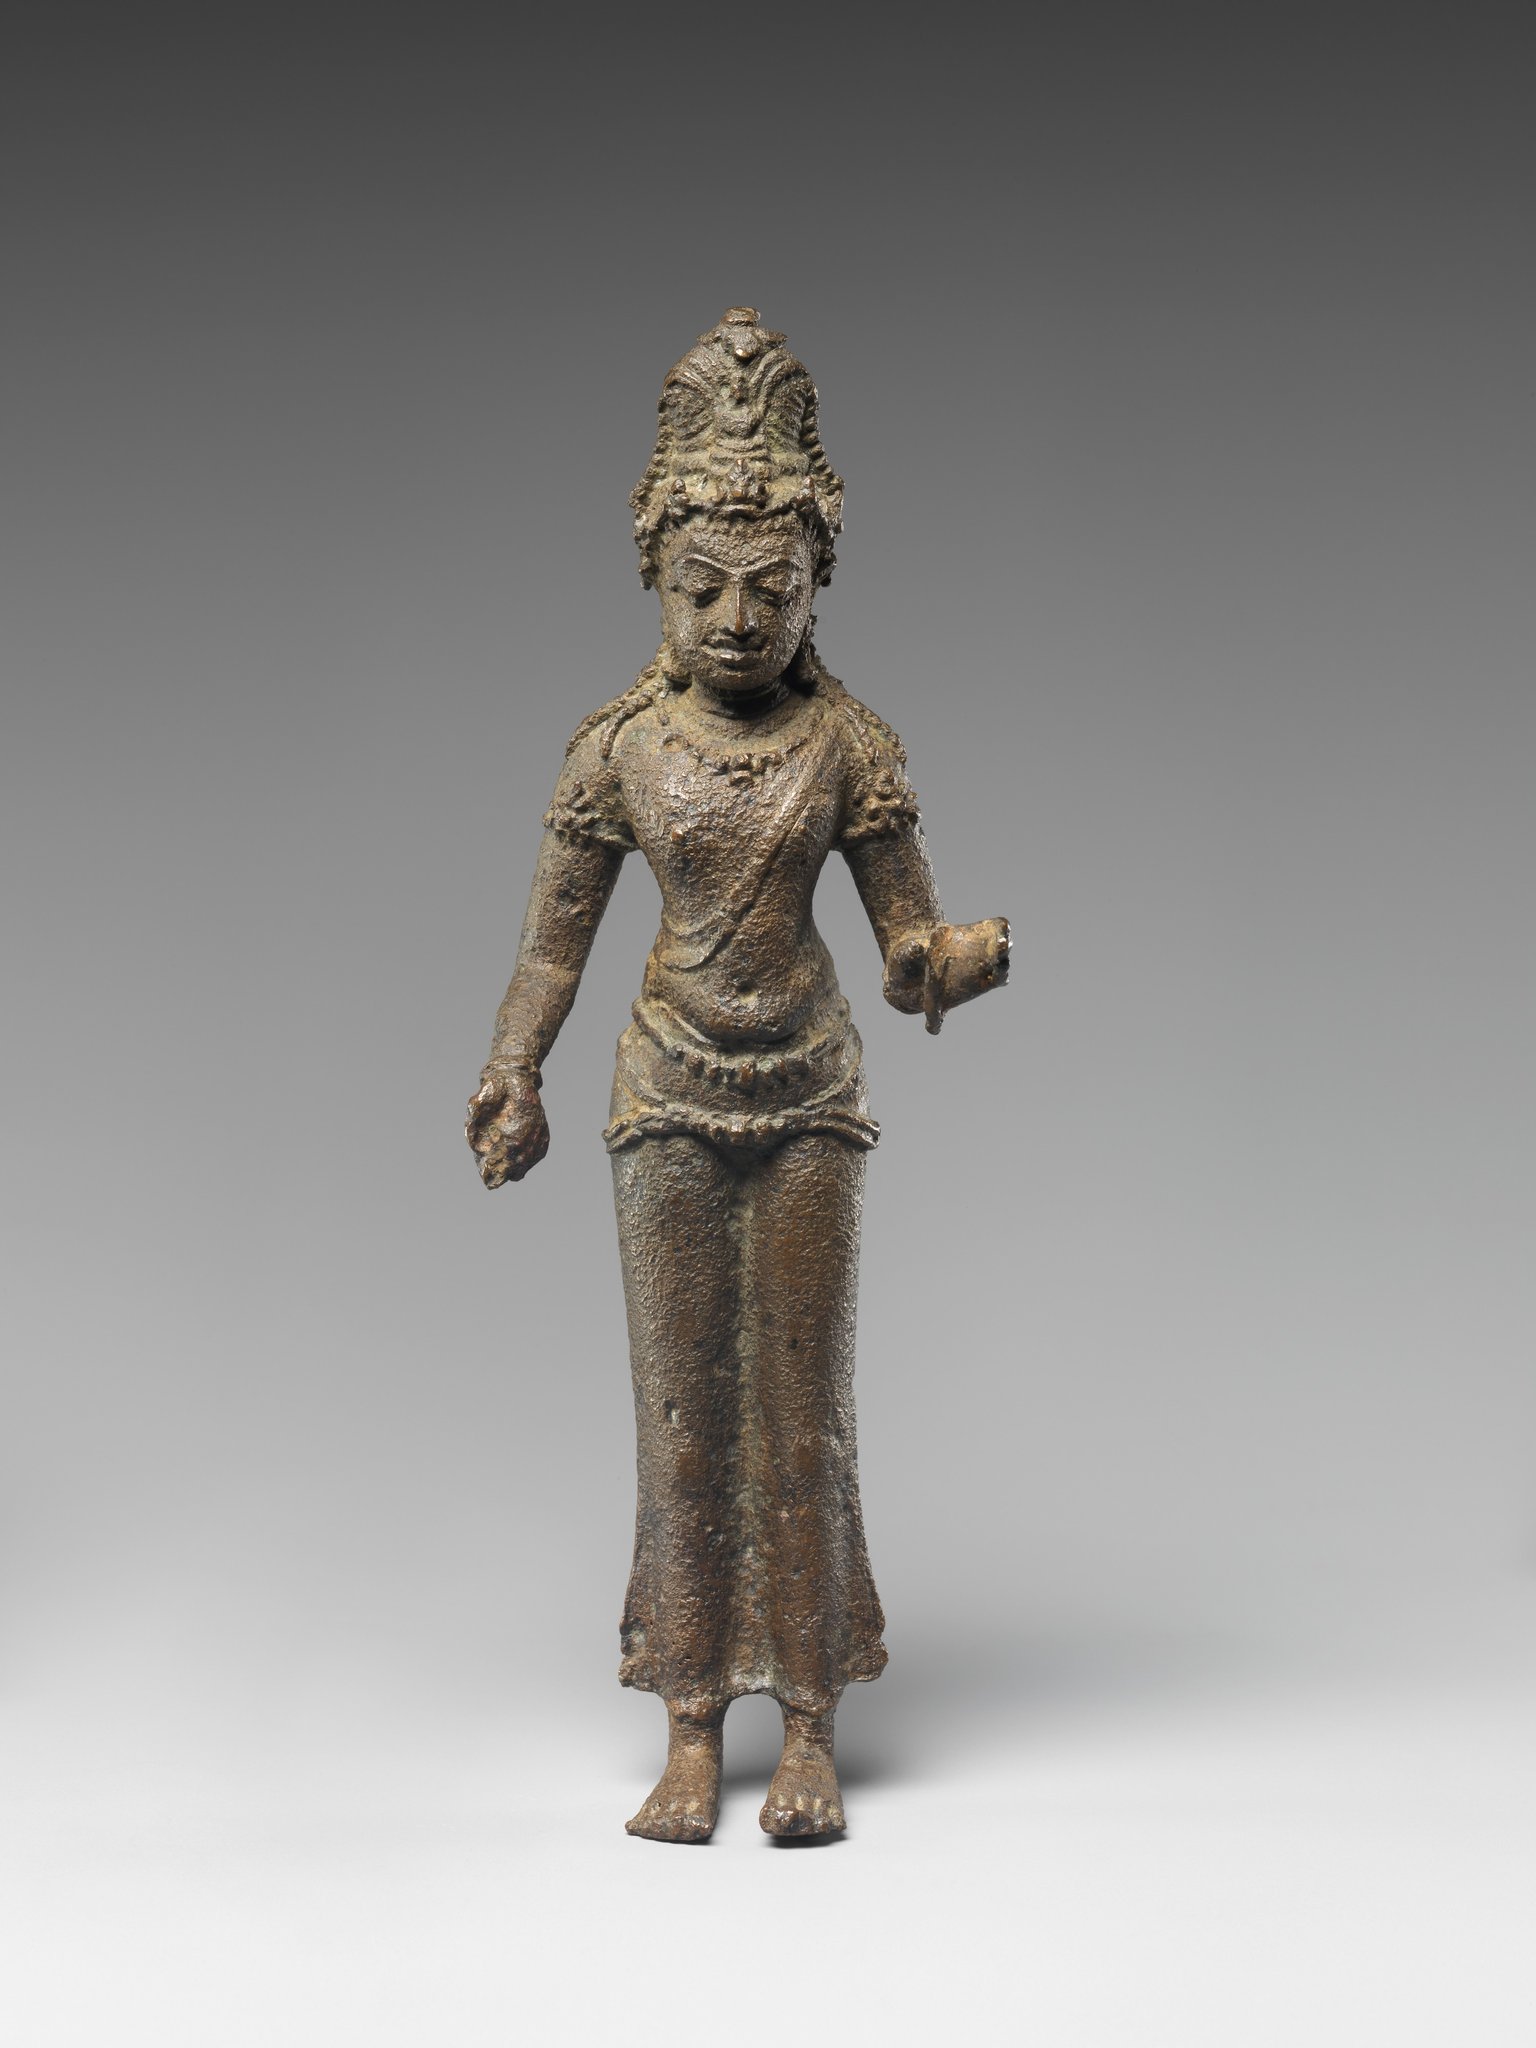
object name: figure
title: Standing Avalokiteshvara, the Bodhisattva of Infinite Compassion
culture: indonesian, sumatran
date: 767-833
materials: bronze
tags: buddhism,avalokiteshvara,bodhisattvas